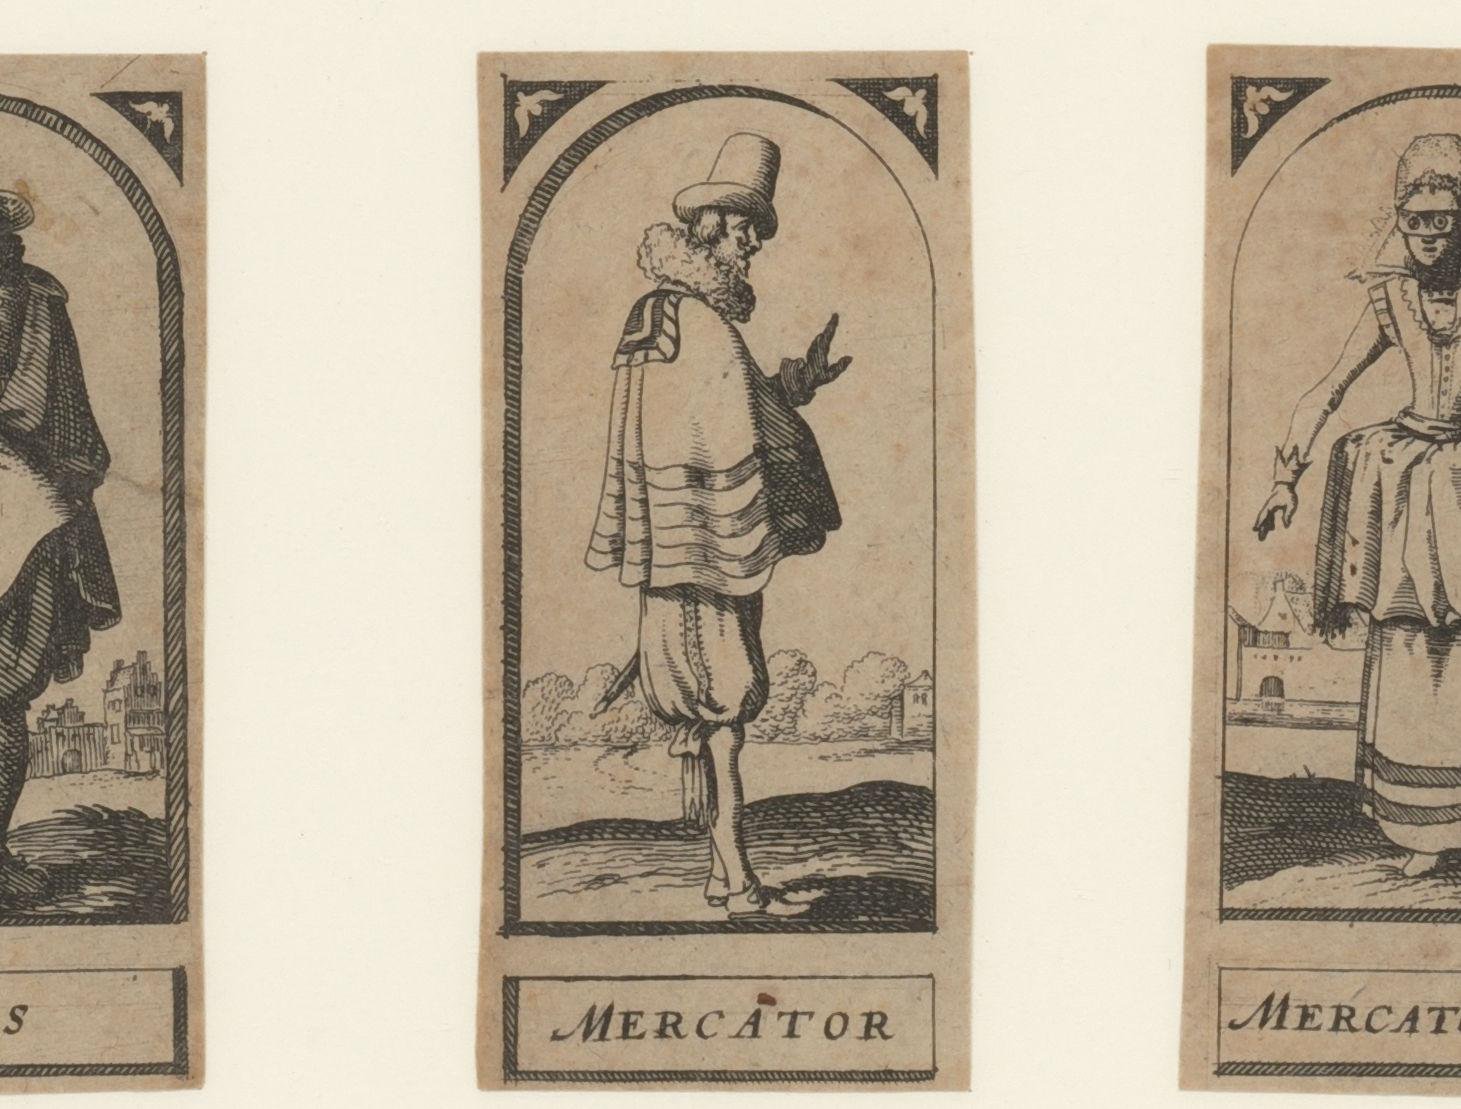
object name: print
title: Mercator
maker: Anonymous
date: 1620-1699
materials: paper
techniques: etching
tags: folk costume, regional costume, merchant, salesman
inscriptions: stamp, collector's mark: Lugt 1641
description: Onderwerpsrubrieken binnen de Atlas Zeden en Gewoonten: Zeden en Gewoonten in Engeren Zin, De Kleeding, Kleederdrachten (tijdvakken), De Spaansche tijd. (1550 – 1600).